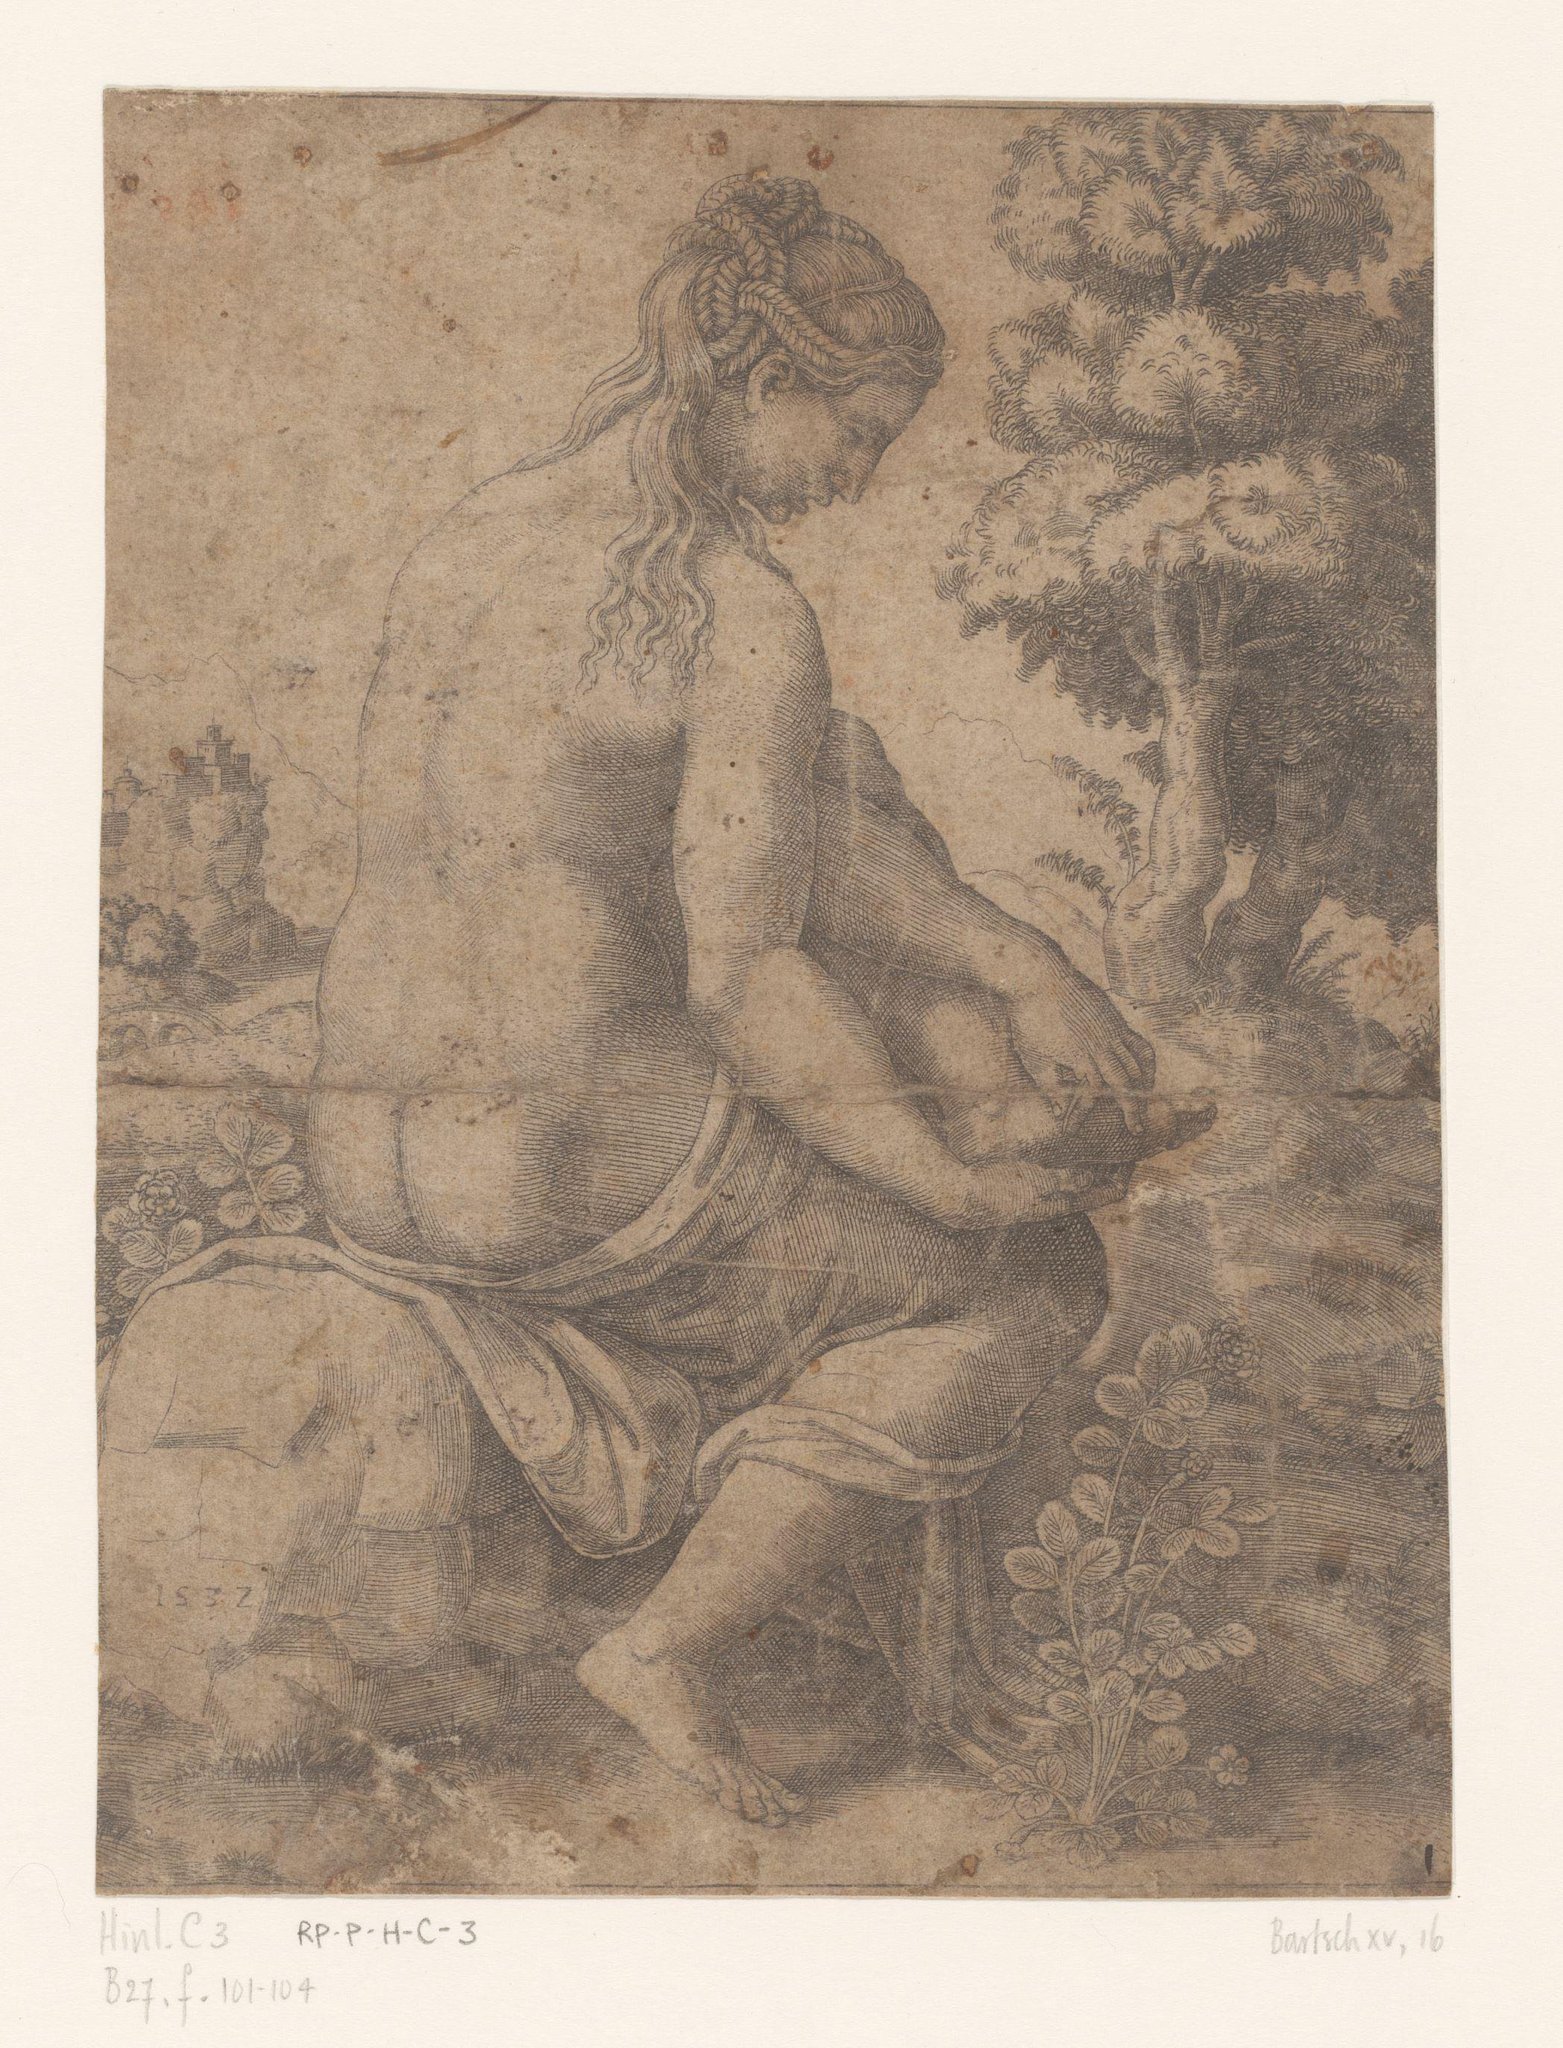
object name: print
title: Venus en de roos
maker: meester van de dobbelsteen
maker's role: print maker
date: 1532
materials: paper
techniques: engraving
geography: italy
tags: city-view, and landscape with man-made constructions, venus wounded by the thorns of a rose-bush; the roses change from white to red (possibly combined with the story of adonis)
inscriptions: collector's mark: Lugt 11, number: ‘1’, collector's mark: ‘Hinloopen’, collector's mark: Lugt 10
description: Venus zit op een rots in een landschap. Ze haalt een doorn van een rozenstruik uit haar voet.